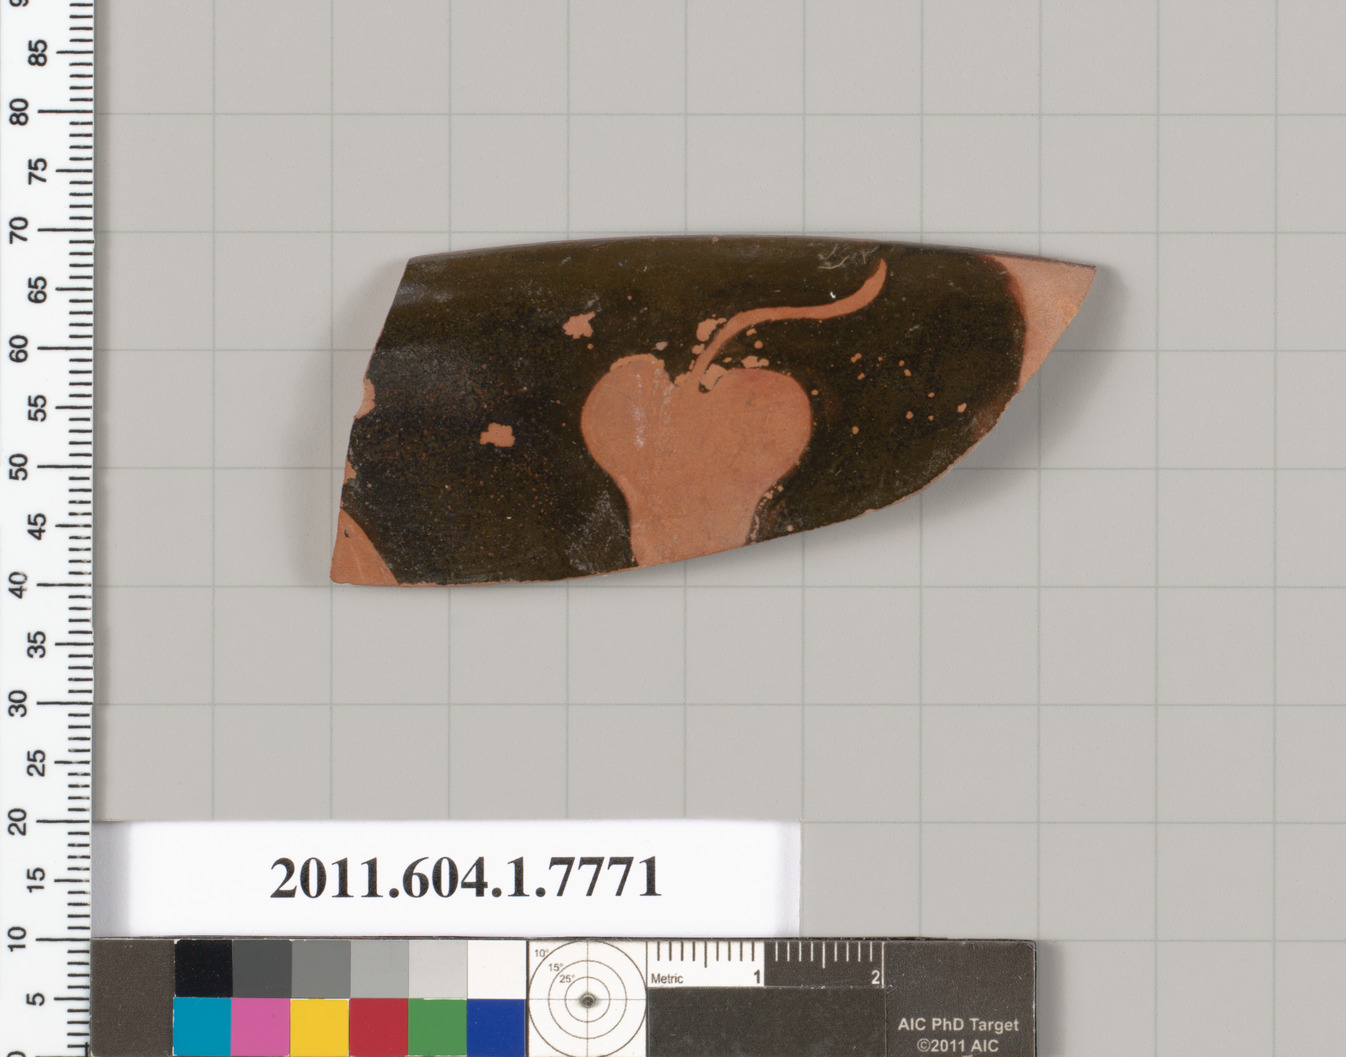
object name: kylix fragment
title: Terracotta rim fragment of a kylix (drinking cup)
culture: greek, attic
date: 460-450 BCE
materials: terracotta